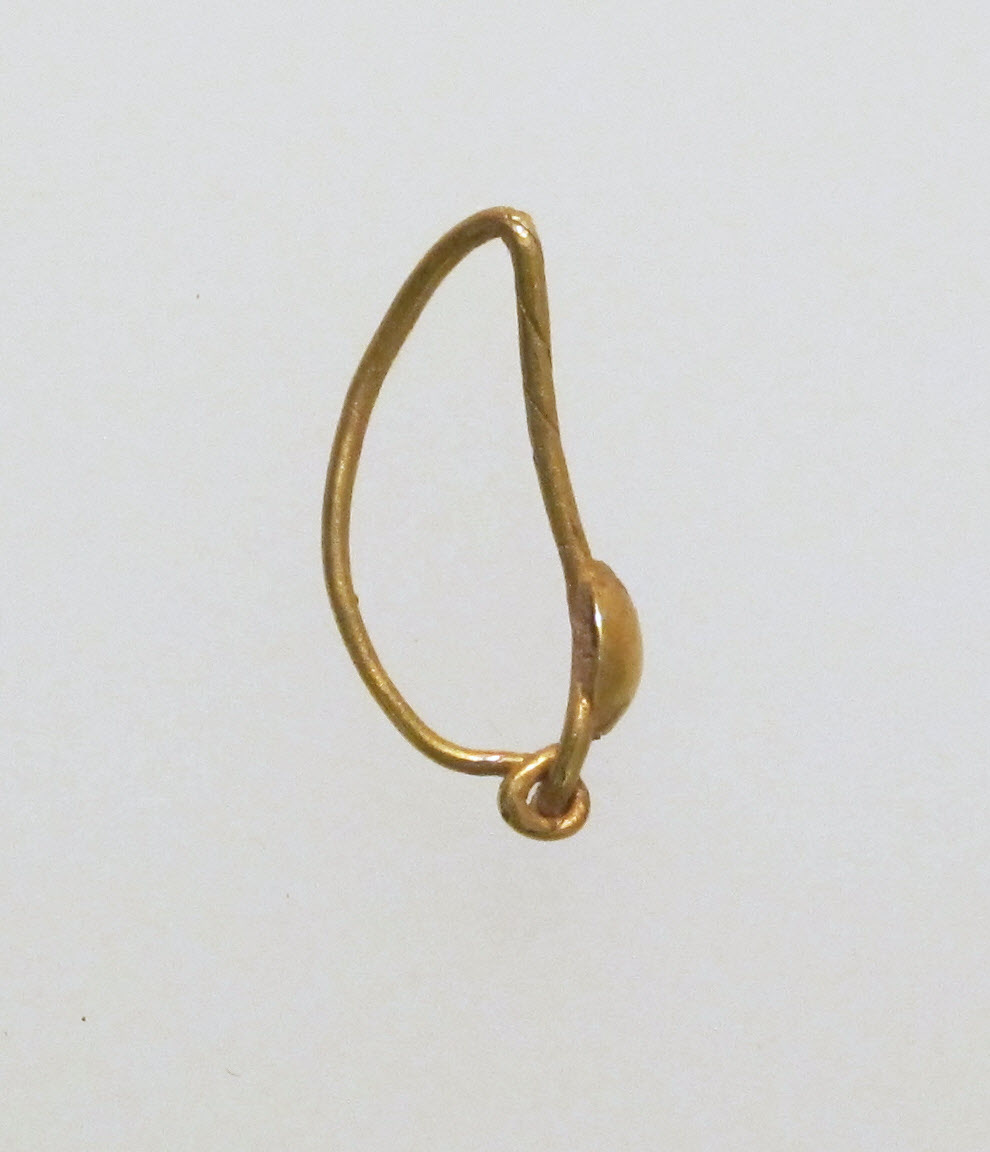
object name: earring with disc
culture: etruscan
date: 900-100 BCE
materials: gold